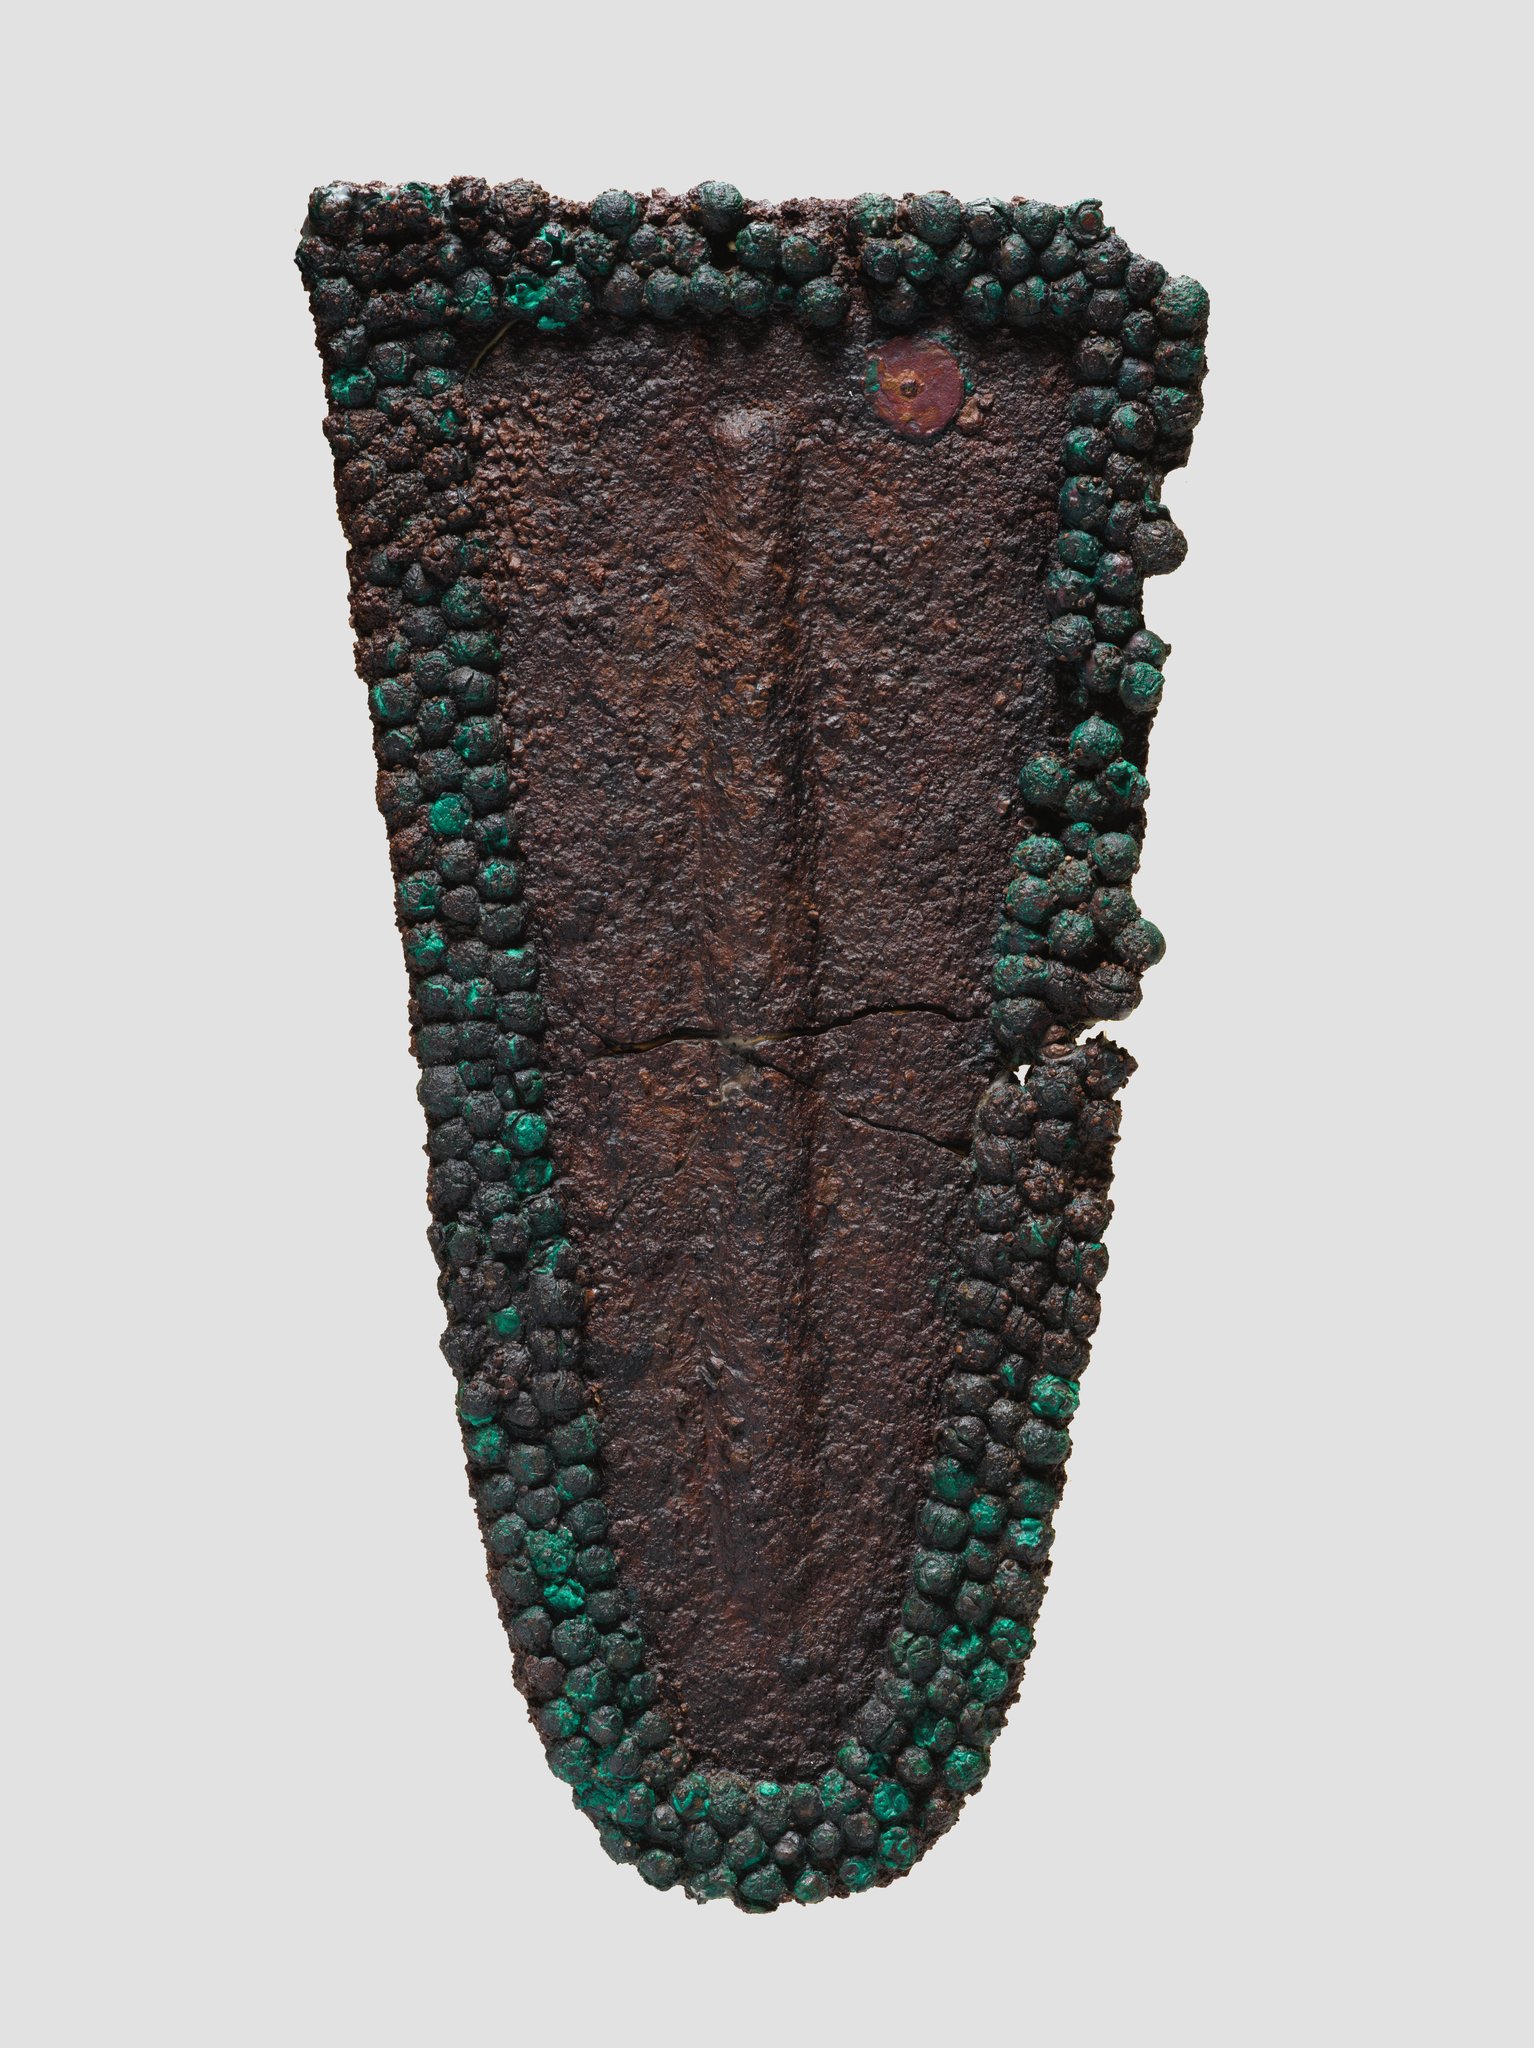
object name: clothing decoration or armor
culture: iranian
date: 900-801 BCE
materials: bronze, iron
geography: iran